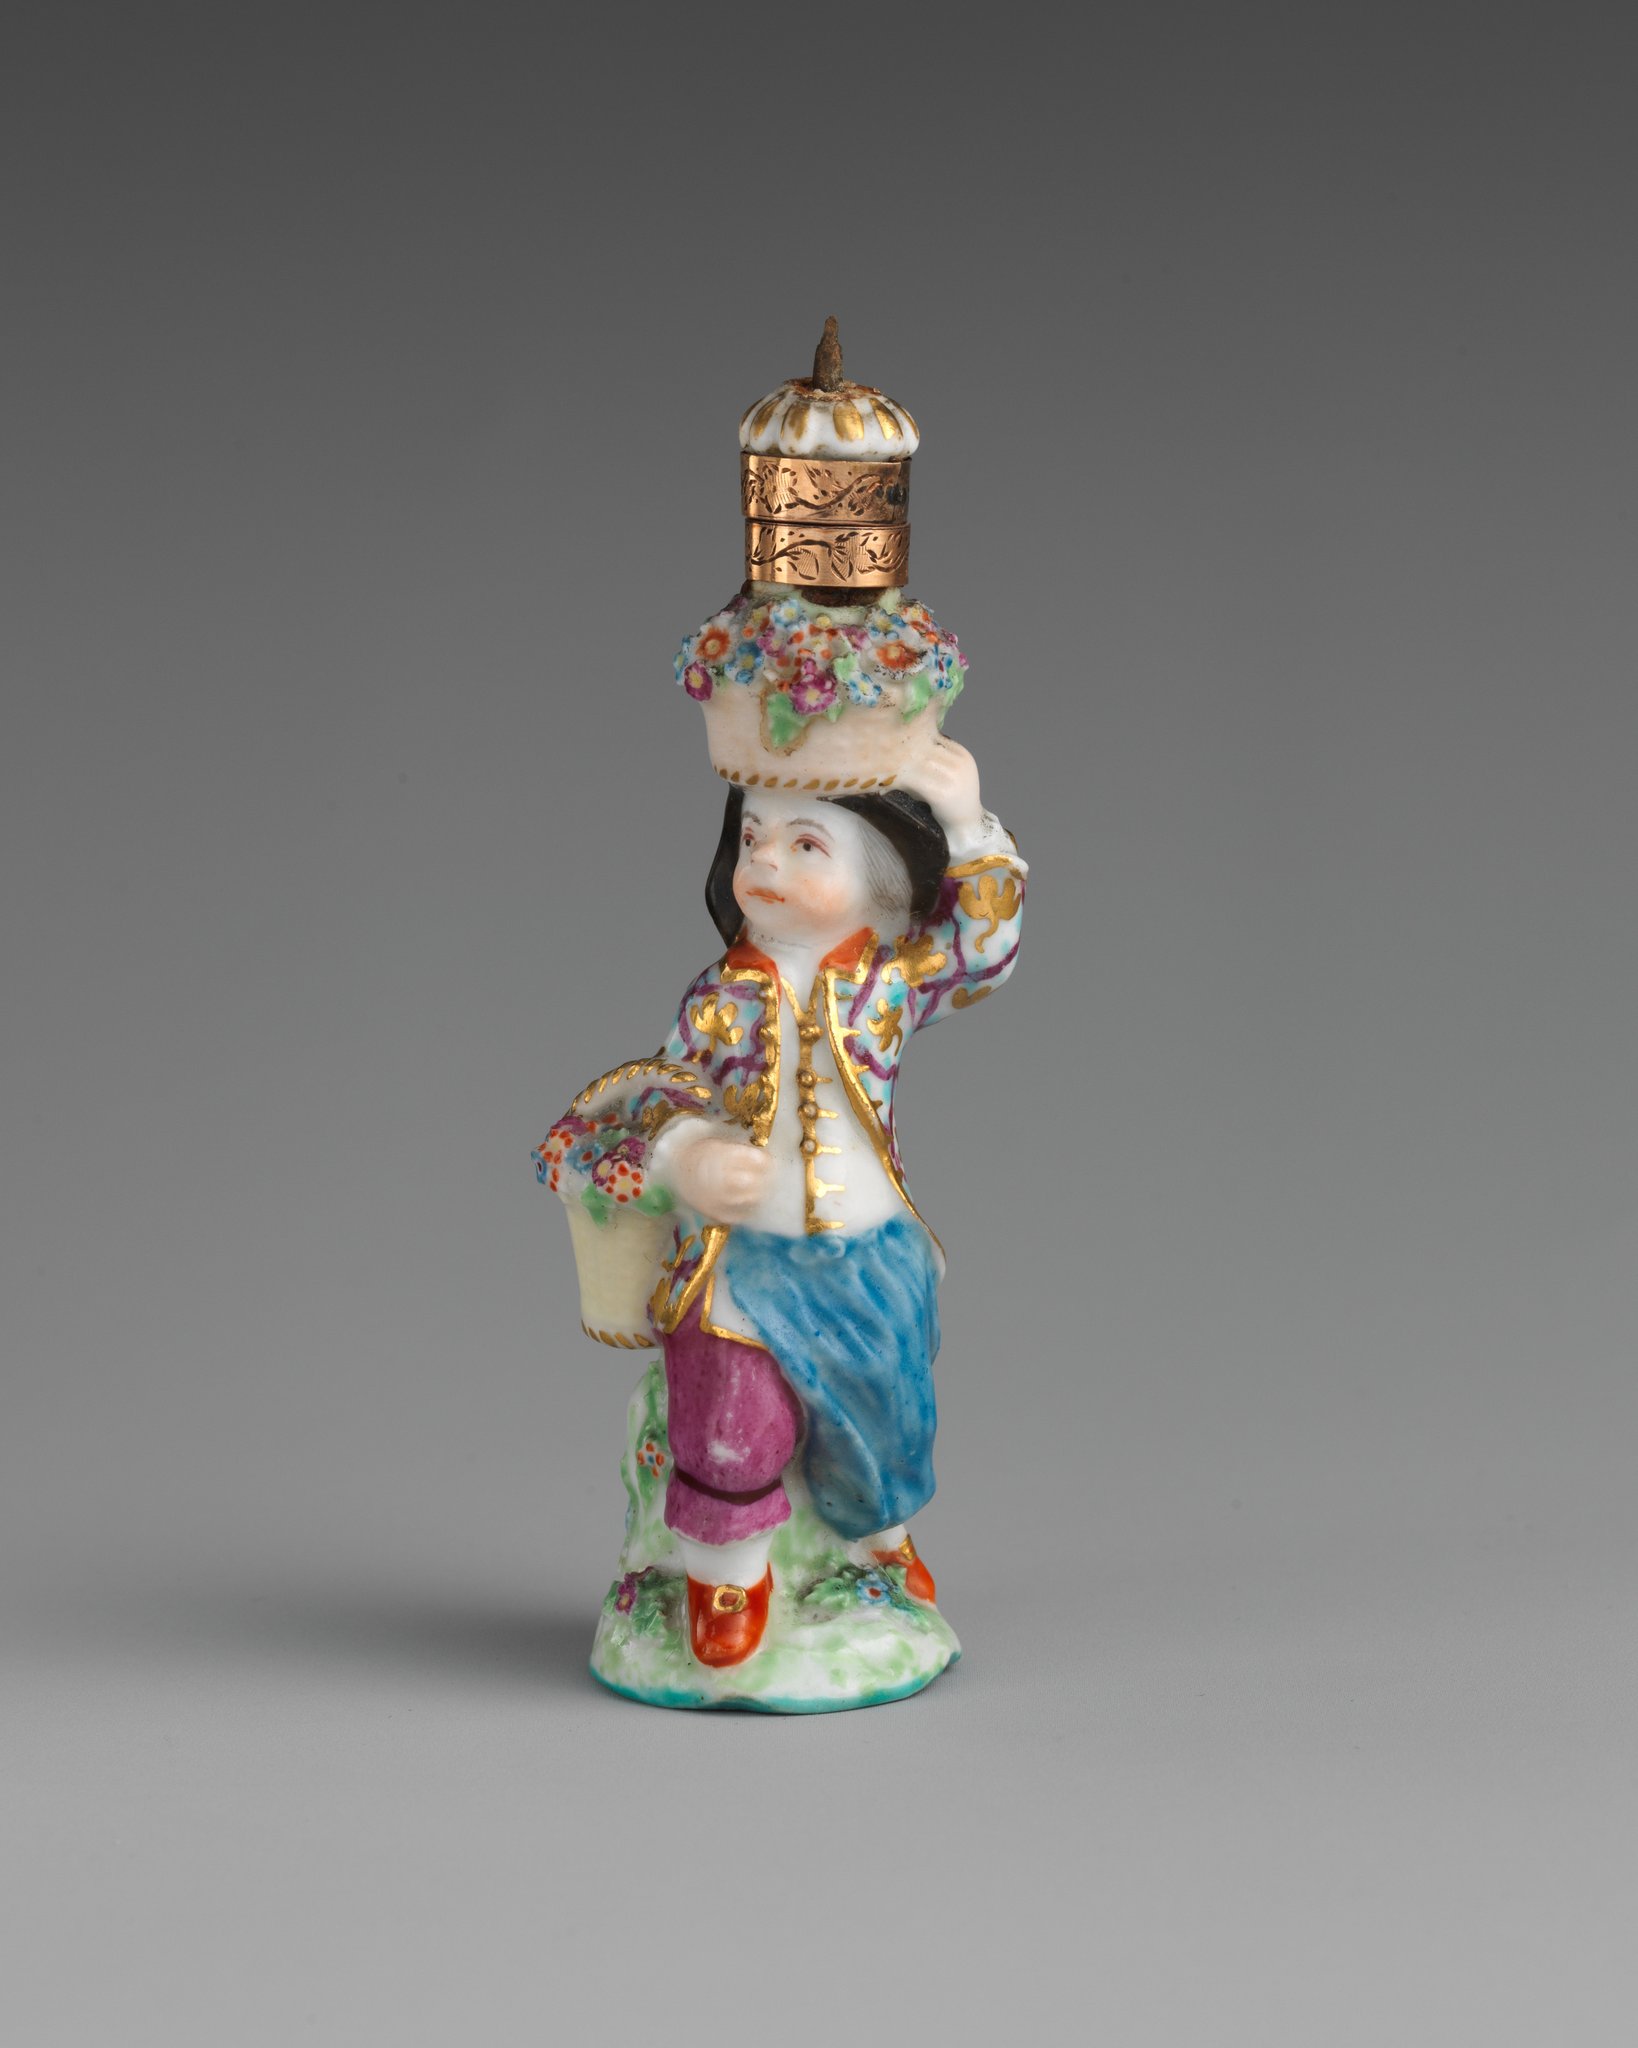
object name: toy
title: Boy gardener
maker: chelsea porcelain manufactory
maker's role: factory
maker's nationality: british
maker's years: 1744-1784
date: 1760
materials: soft paste porcelain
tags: boys,gardeners